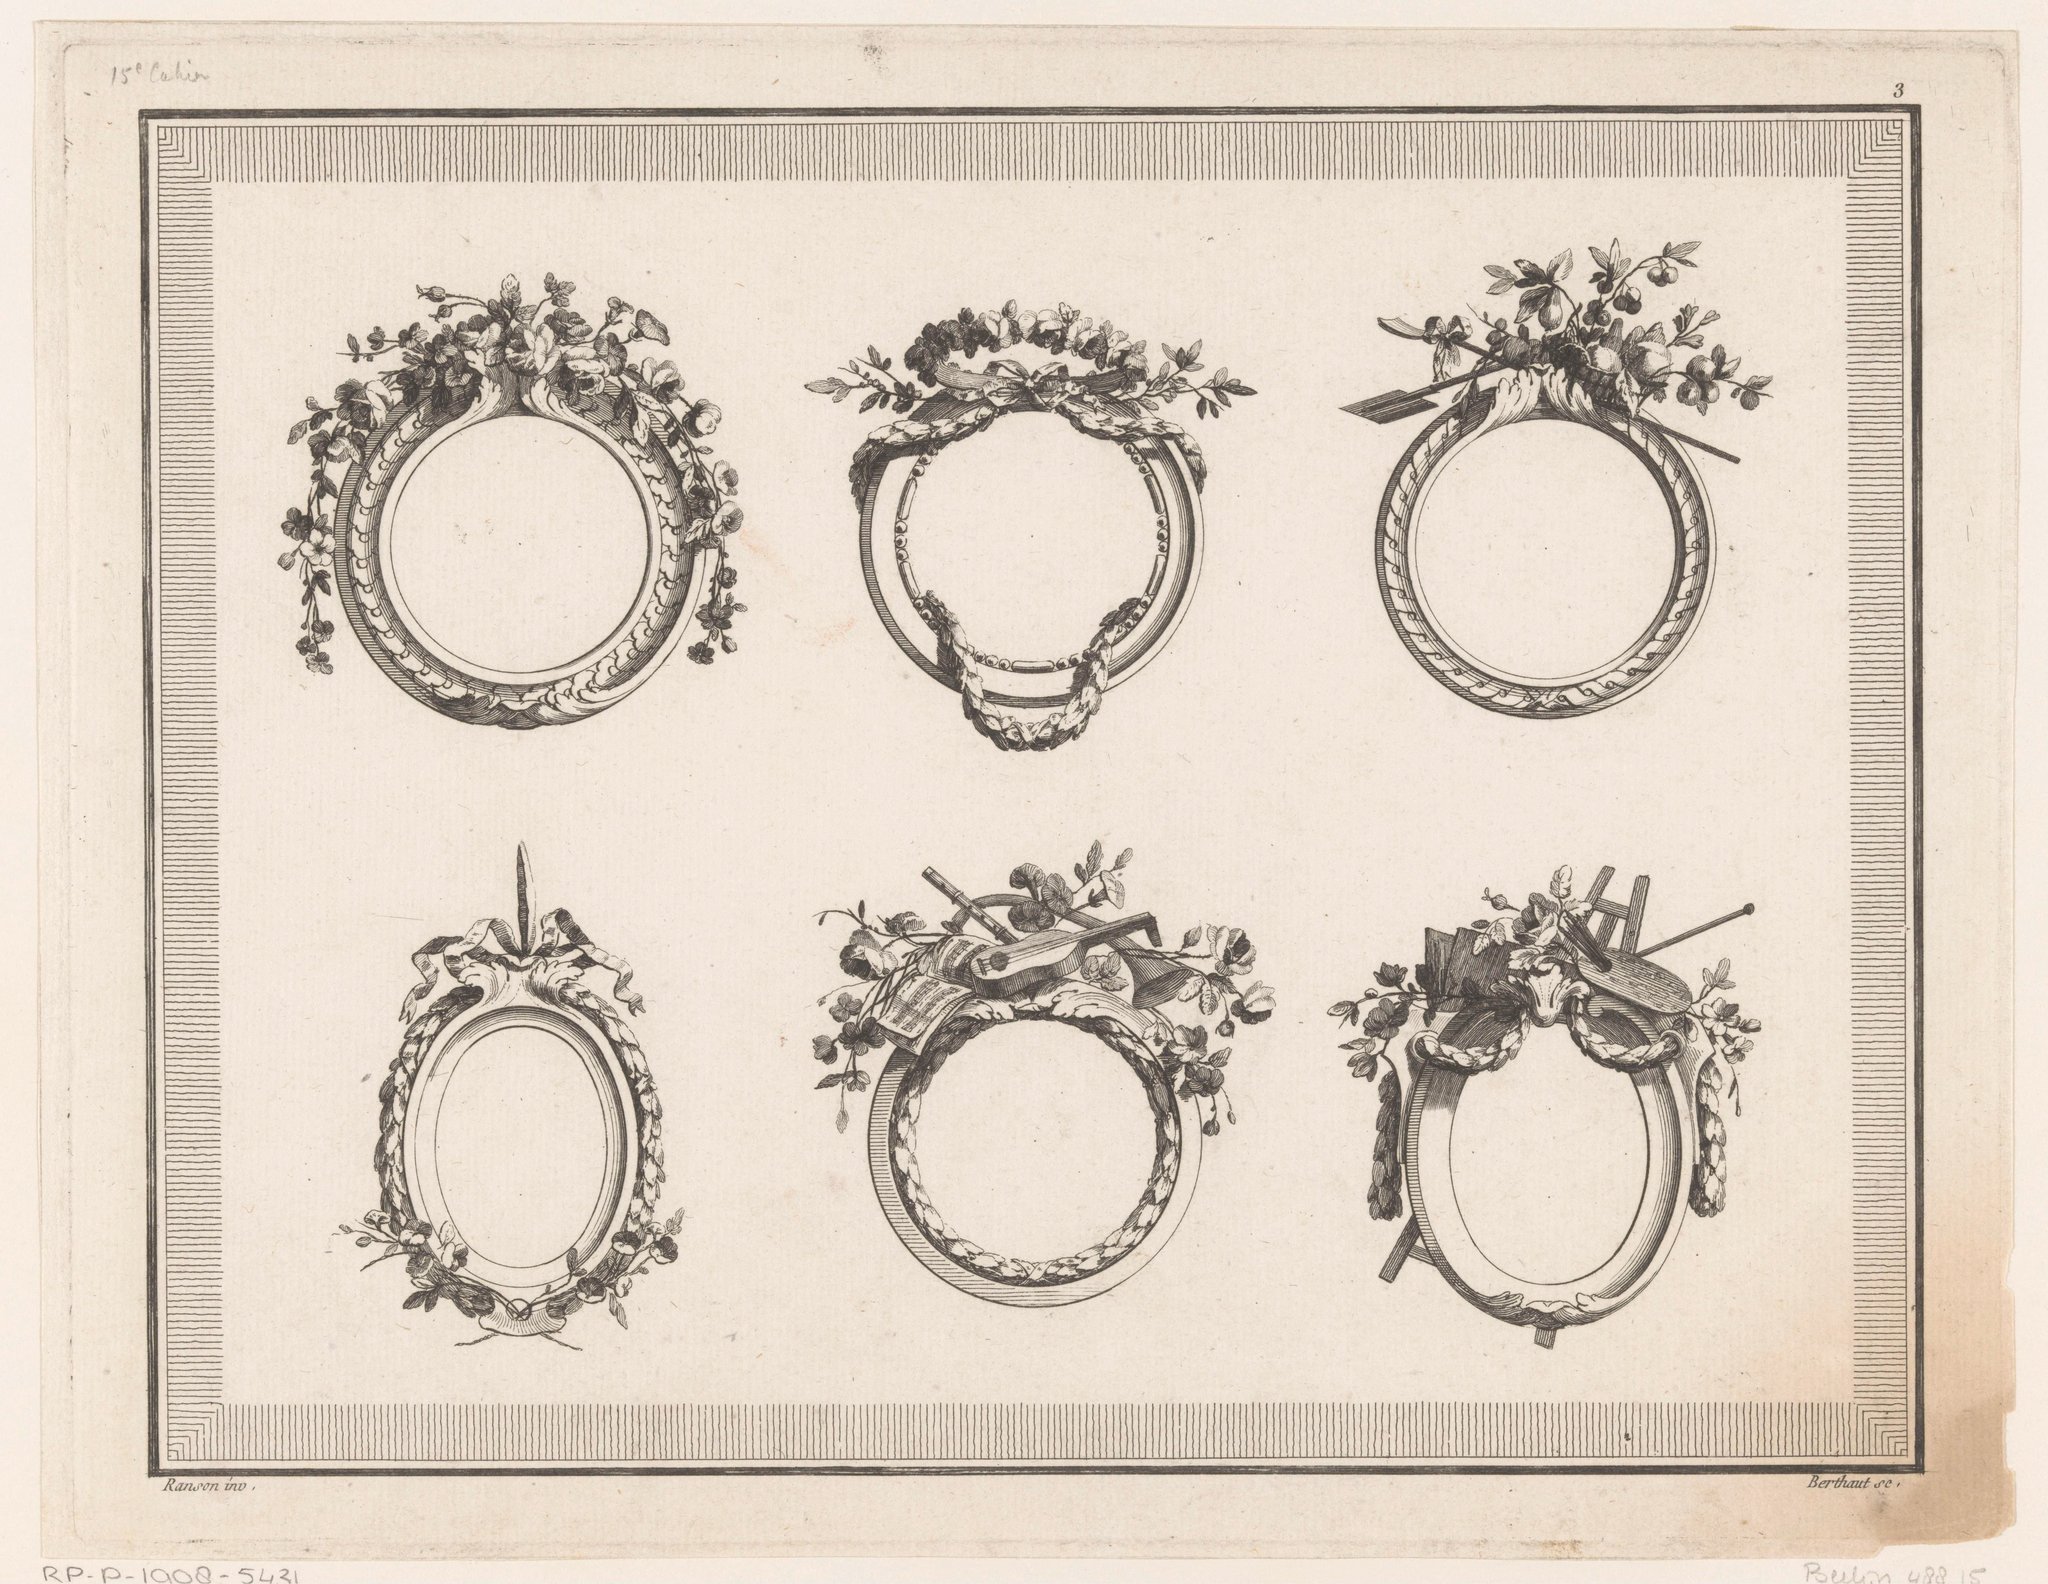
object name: print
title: Medaillons met muziekinstrumenten en schildersattributen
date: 1778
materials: paper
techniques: etching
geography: paris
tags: musical instruments; group of musical instruments, ornament ~ medallion, tools, implements of painter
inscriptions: collector's mark: Lugt 2228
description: Zes medaillons. Links boven met bloemen. Midden boven met krans en guirlandes. Rechts boven met bloemen, schep en herdersstaf. Links onder met bloemen. Midden onder met muziekinstrumenten. Rechts onder met schildersattributen.